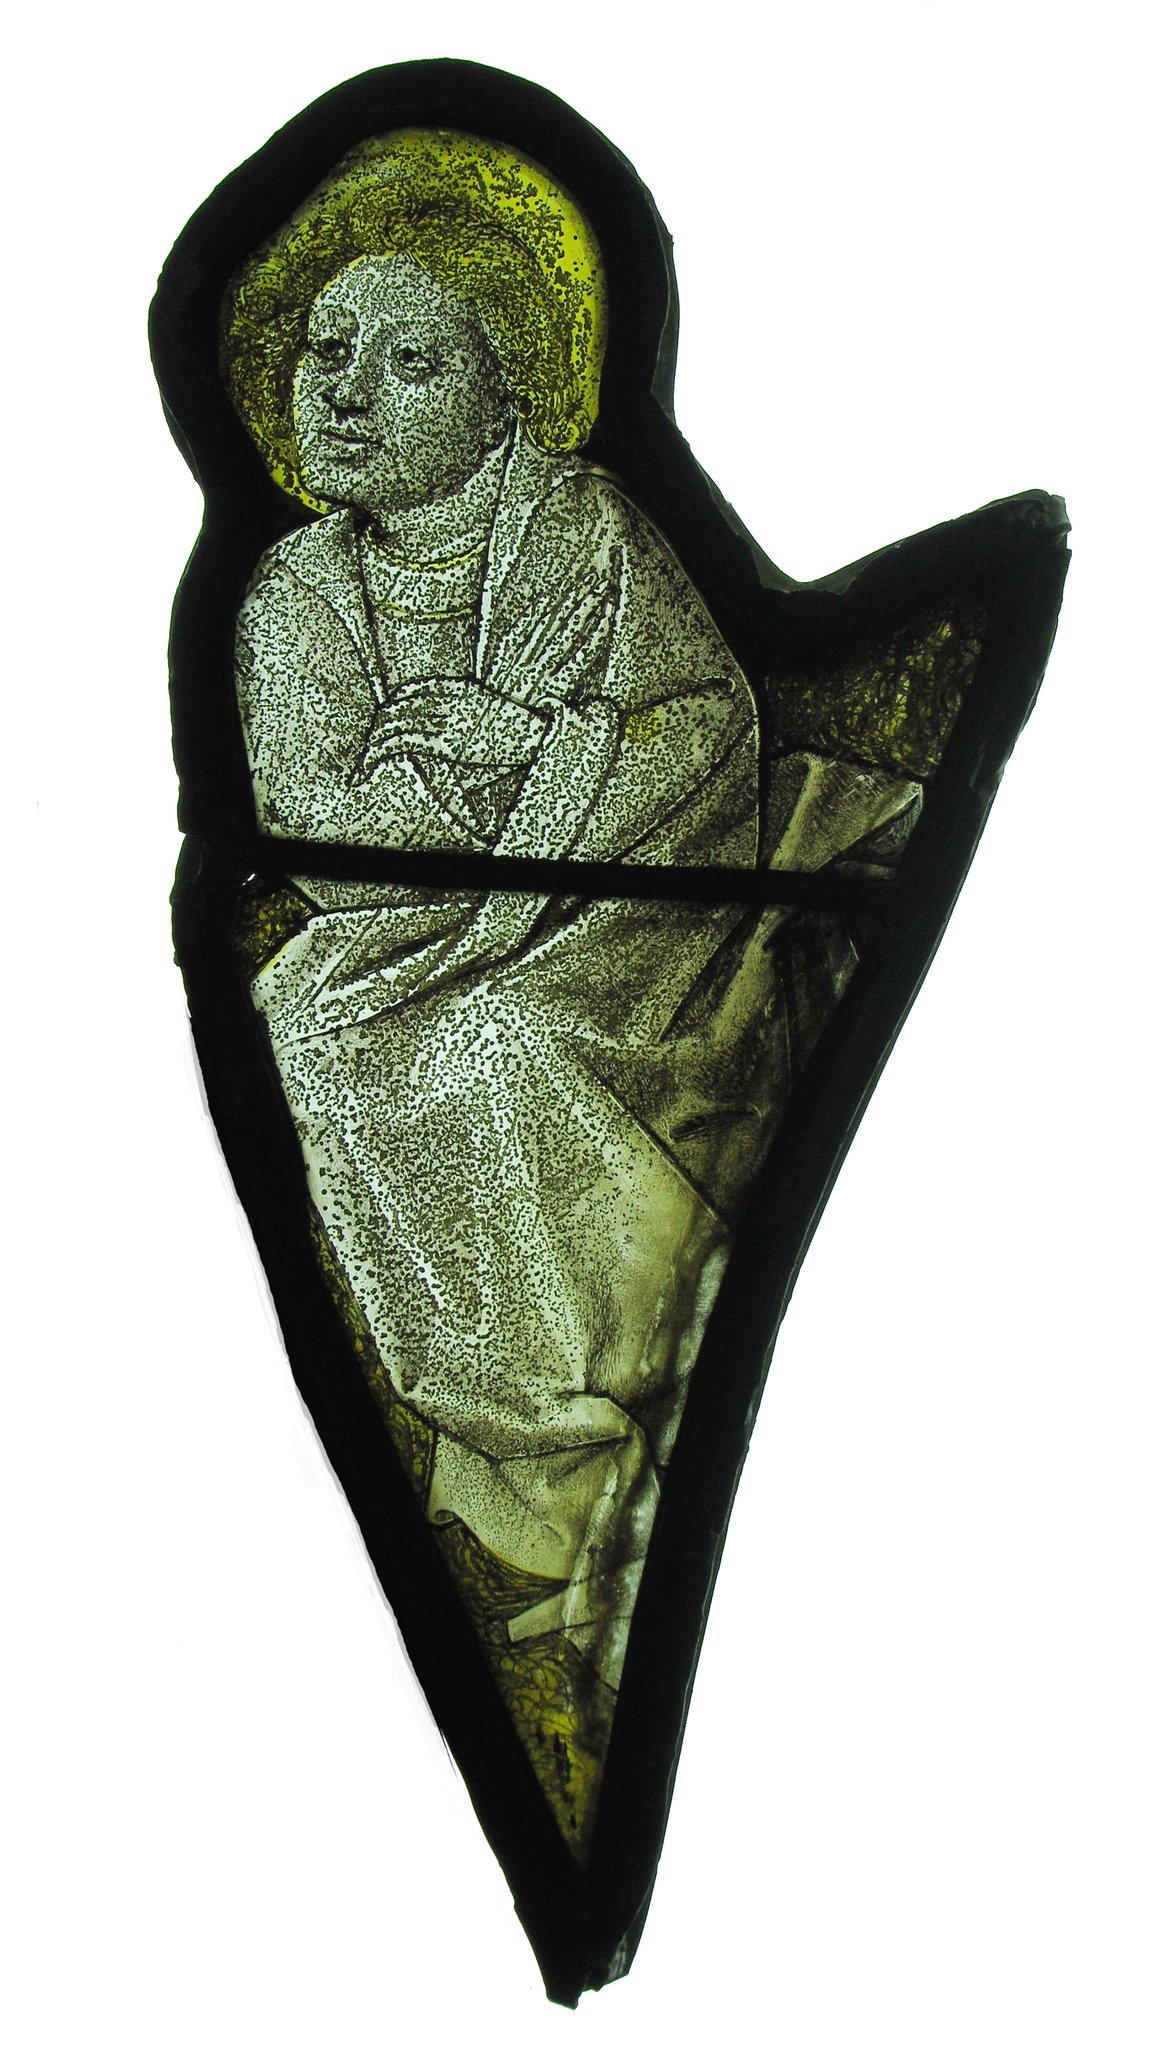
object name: panel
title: Stained Glass Panel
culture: south netherlandish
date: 1401-1500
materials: glass